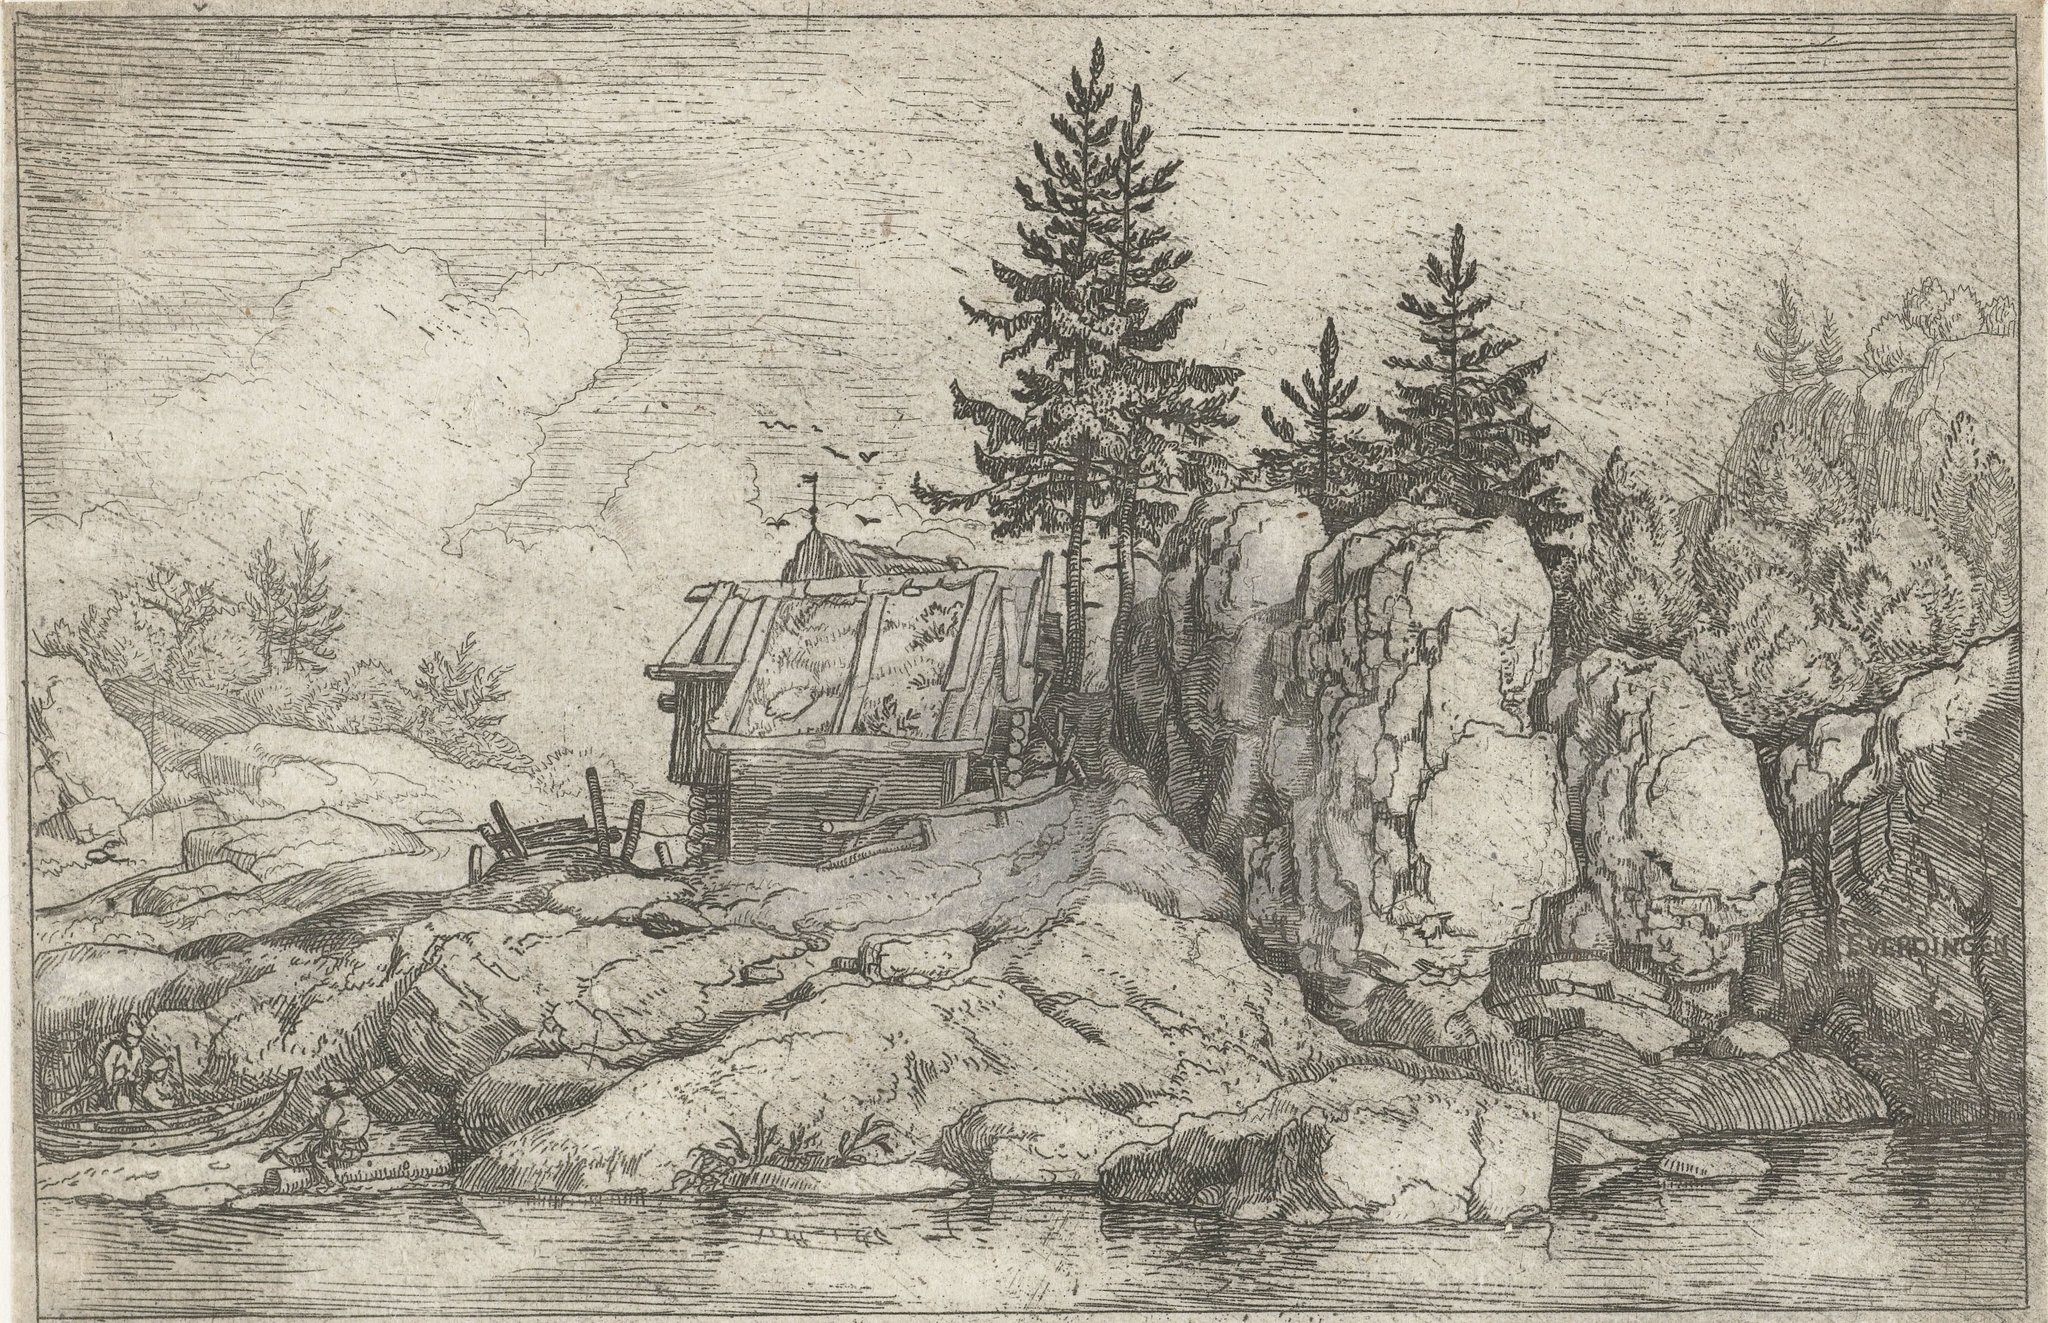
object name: print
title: Landschap met vier sparren bij een hut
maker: allaert van everdingen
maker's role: draughtsman, painter, print maker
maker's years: 1621-1675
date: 1631-1675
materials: paper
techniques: etching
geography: netherlands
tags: farm or solitary house in landscape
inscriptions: collector's mark: Lugt 2228, collector's mark: Lugt 2760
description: Rotslandschap met vier sparren naast een houten hut met rieten dak. Op de oever op de voorgrond vier personen en een roeiboot.